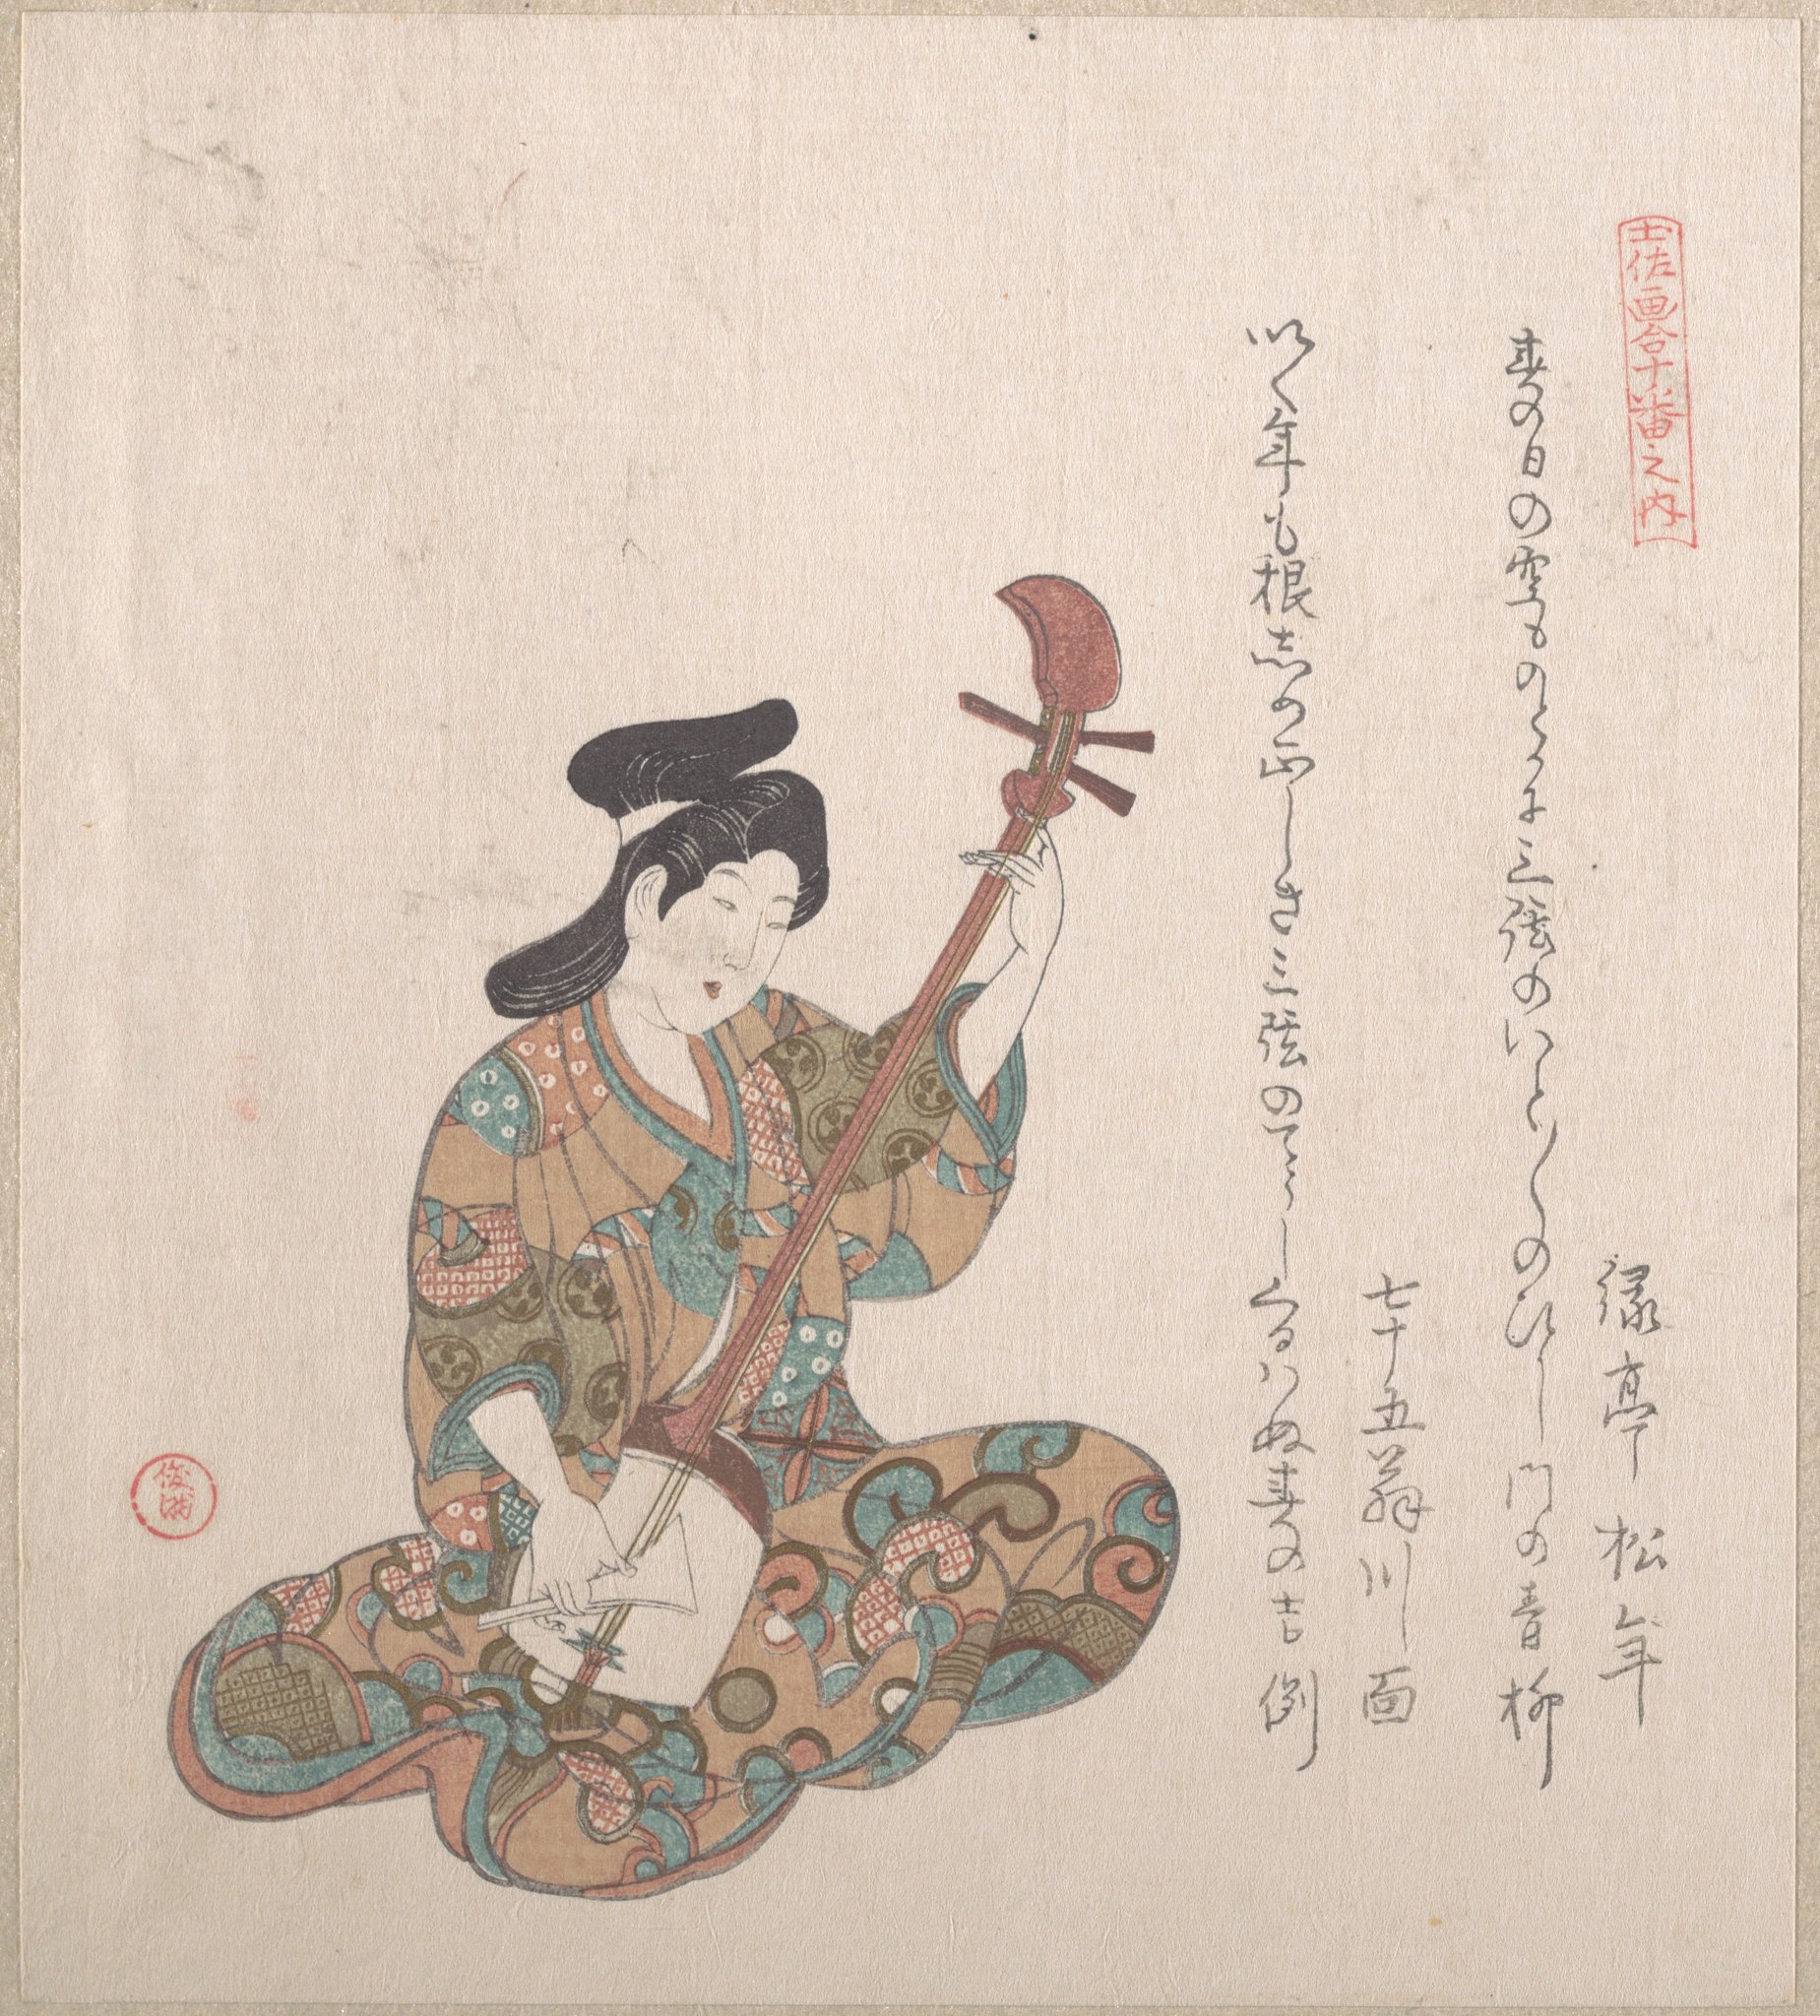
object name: print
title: Woman Playing on the Shamisen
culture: japanese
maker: kubo shunman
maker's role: artist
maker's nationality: japanese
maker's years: 1757-1820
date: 1815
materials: ink, paper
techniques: surimono, woodblock print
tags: musical instruments,women